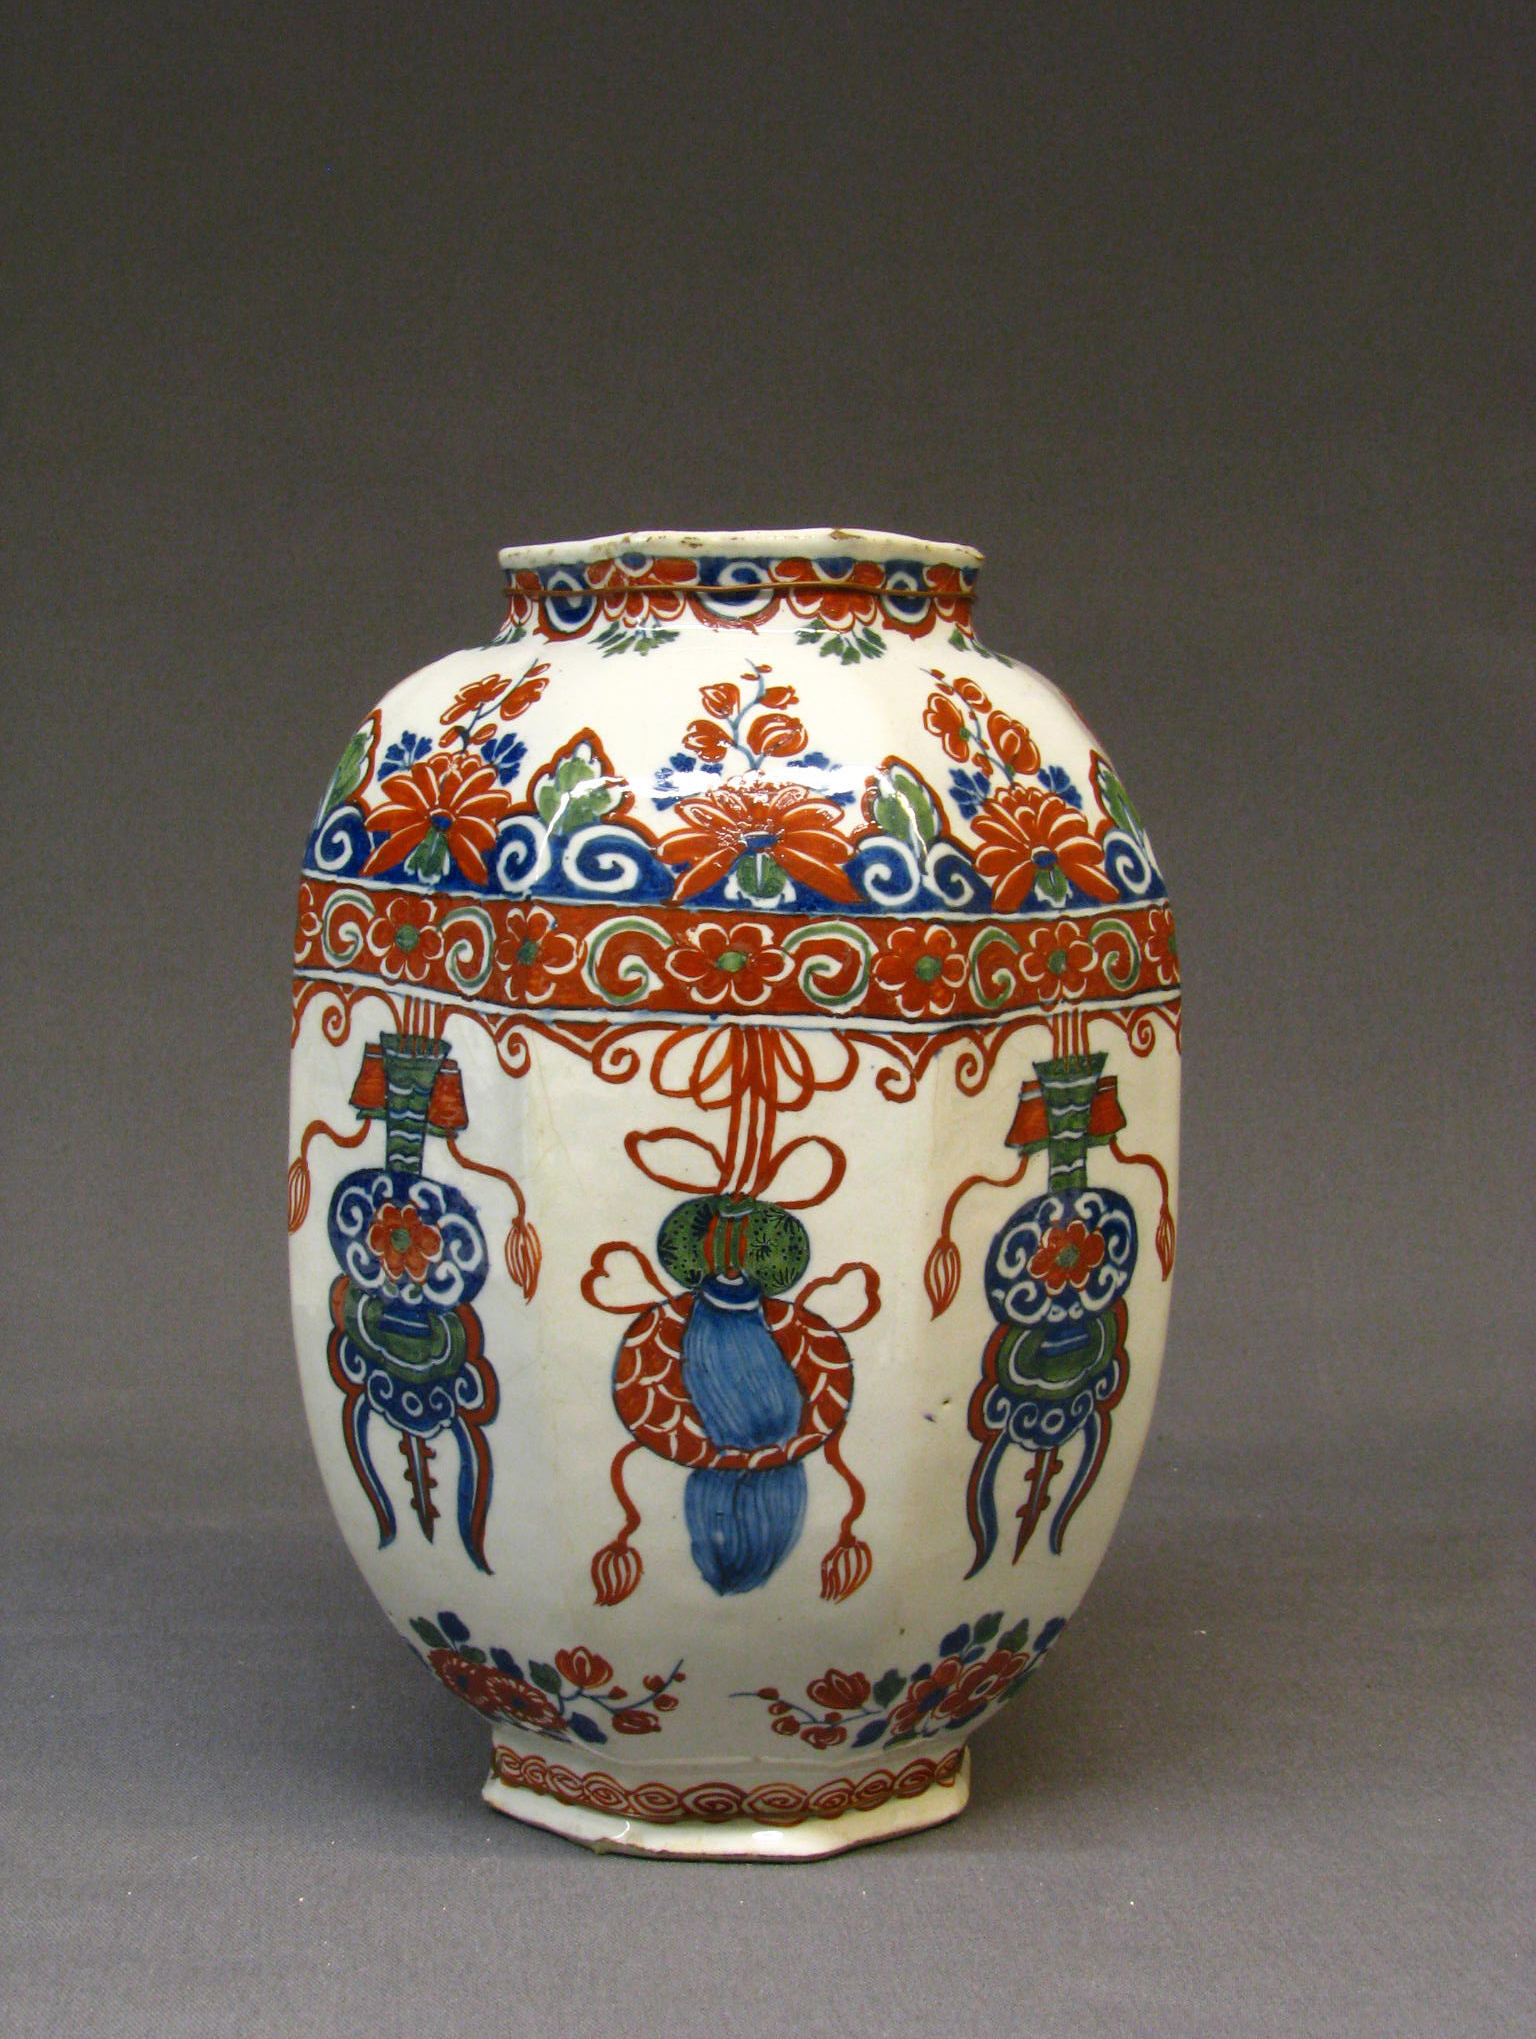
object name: vase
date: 1801-1900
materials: earthenware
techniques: glazing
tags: bees,flowers